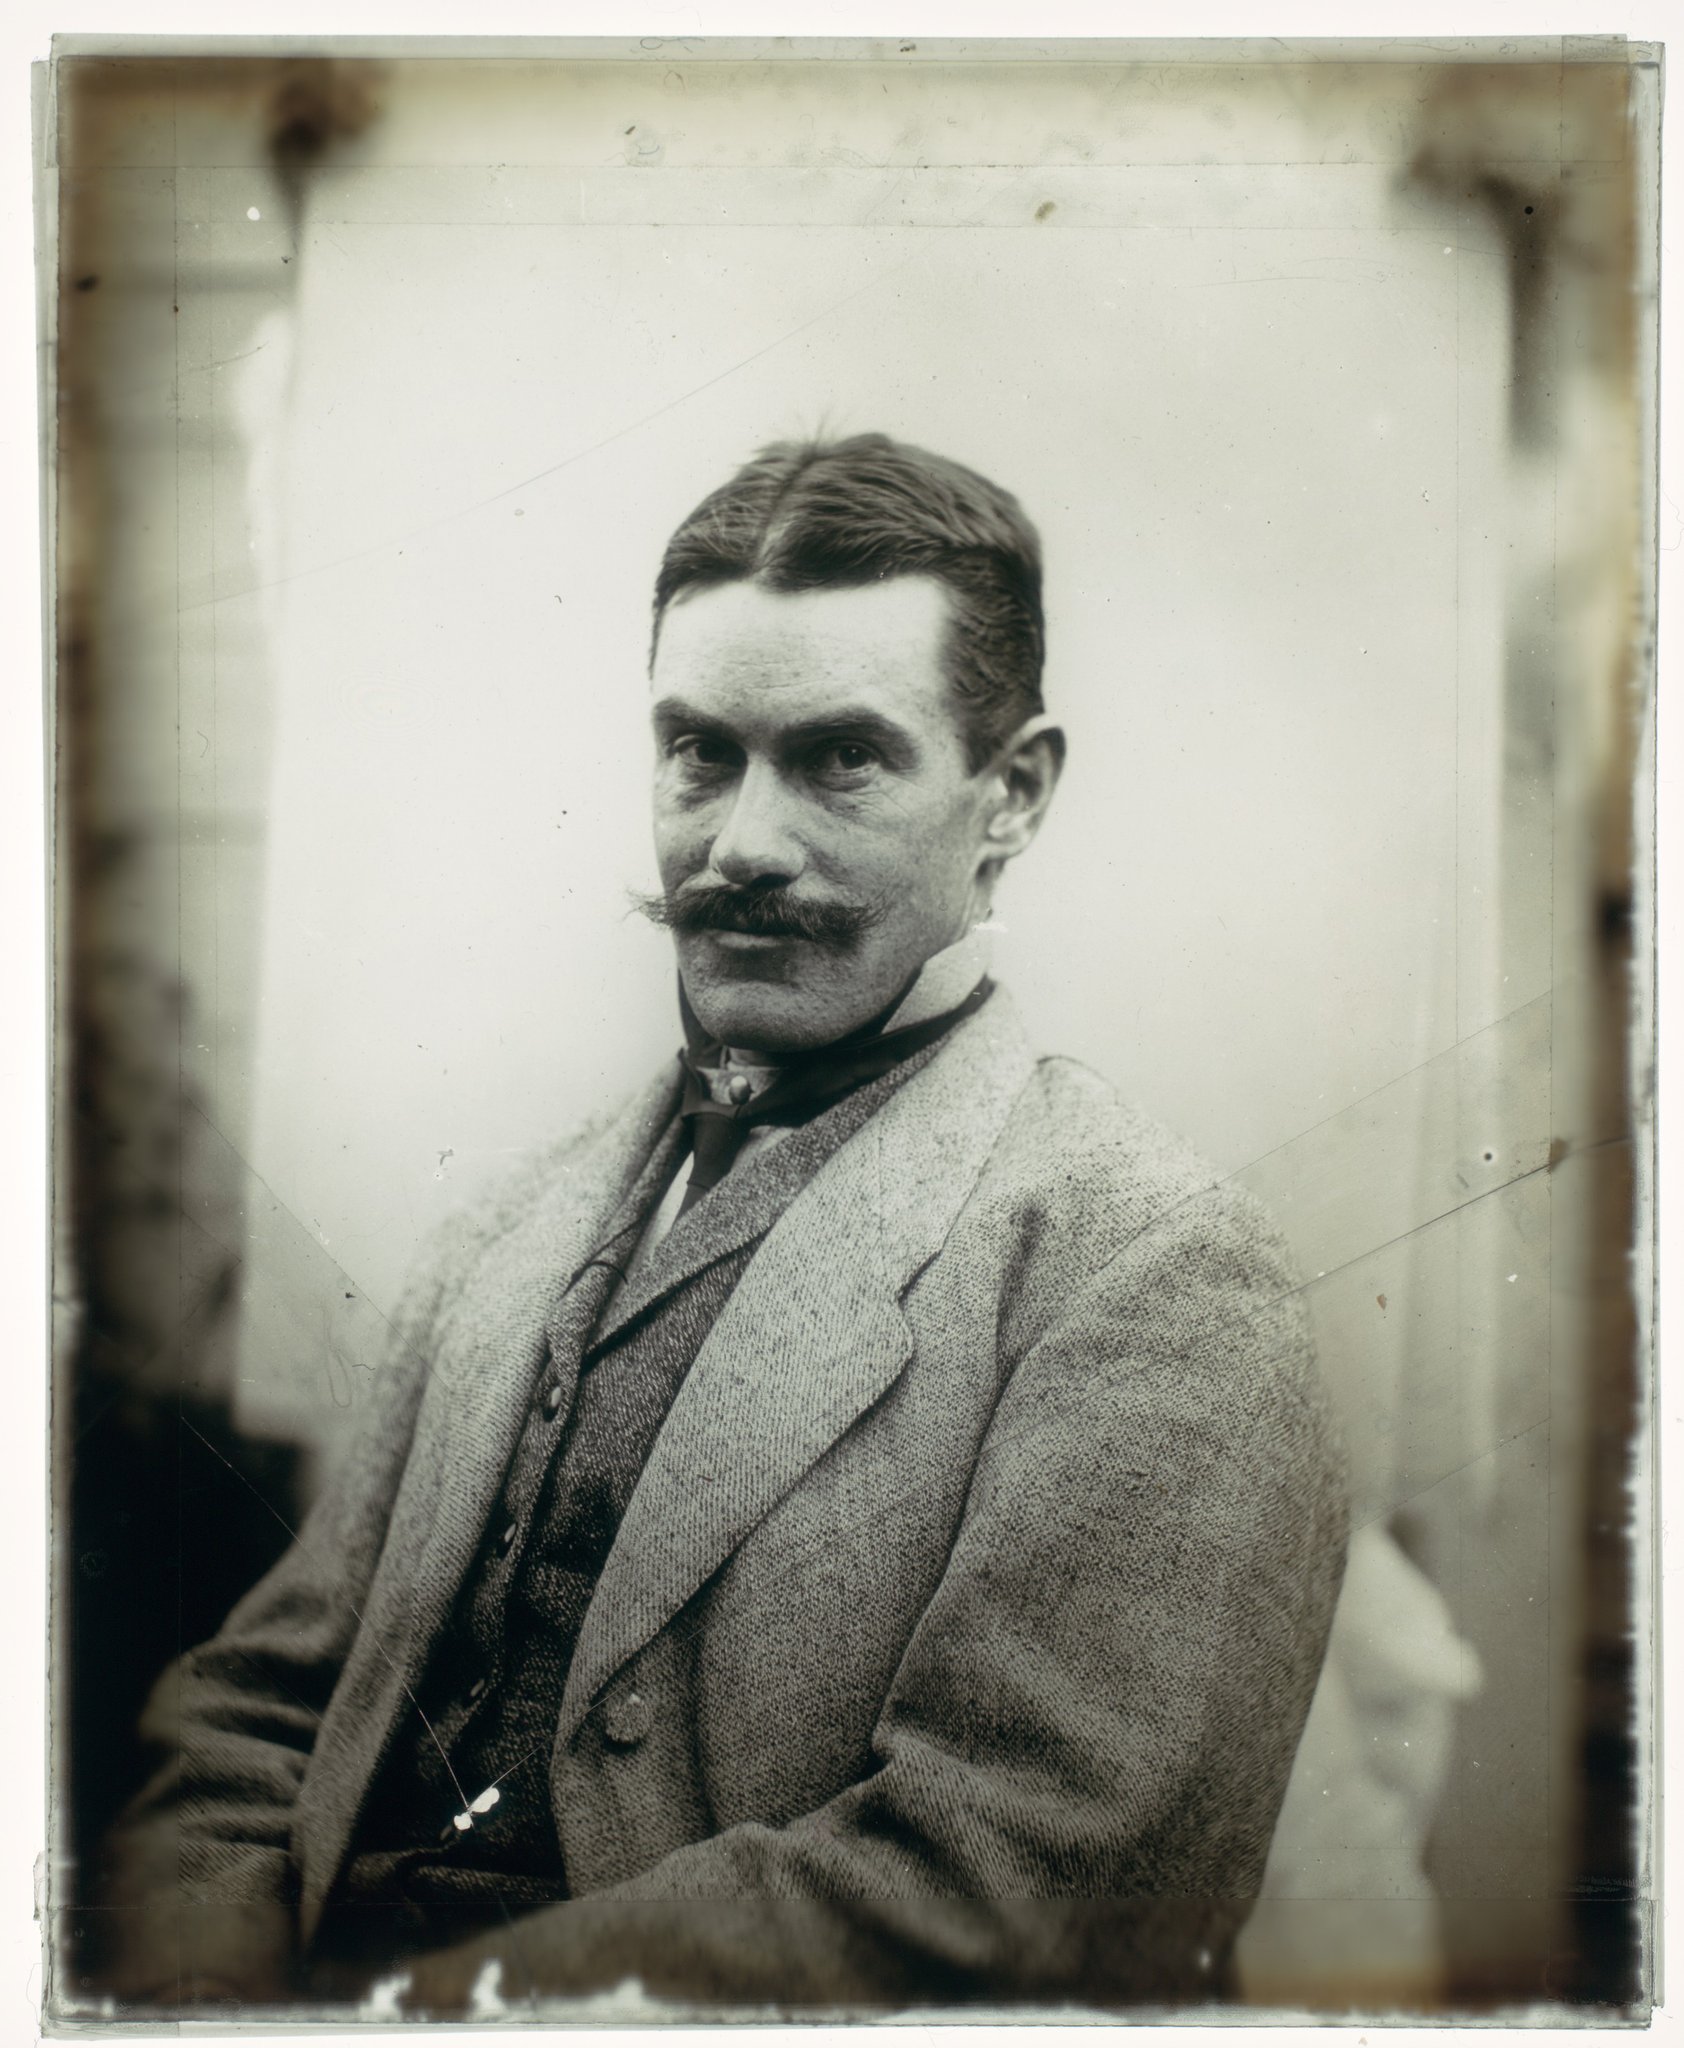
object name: glass positive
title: Frank MacDowell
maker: thomas eakins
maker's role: artist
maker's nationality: american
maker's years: 1844-1916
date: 1880-1889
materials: glass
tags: men,portraits